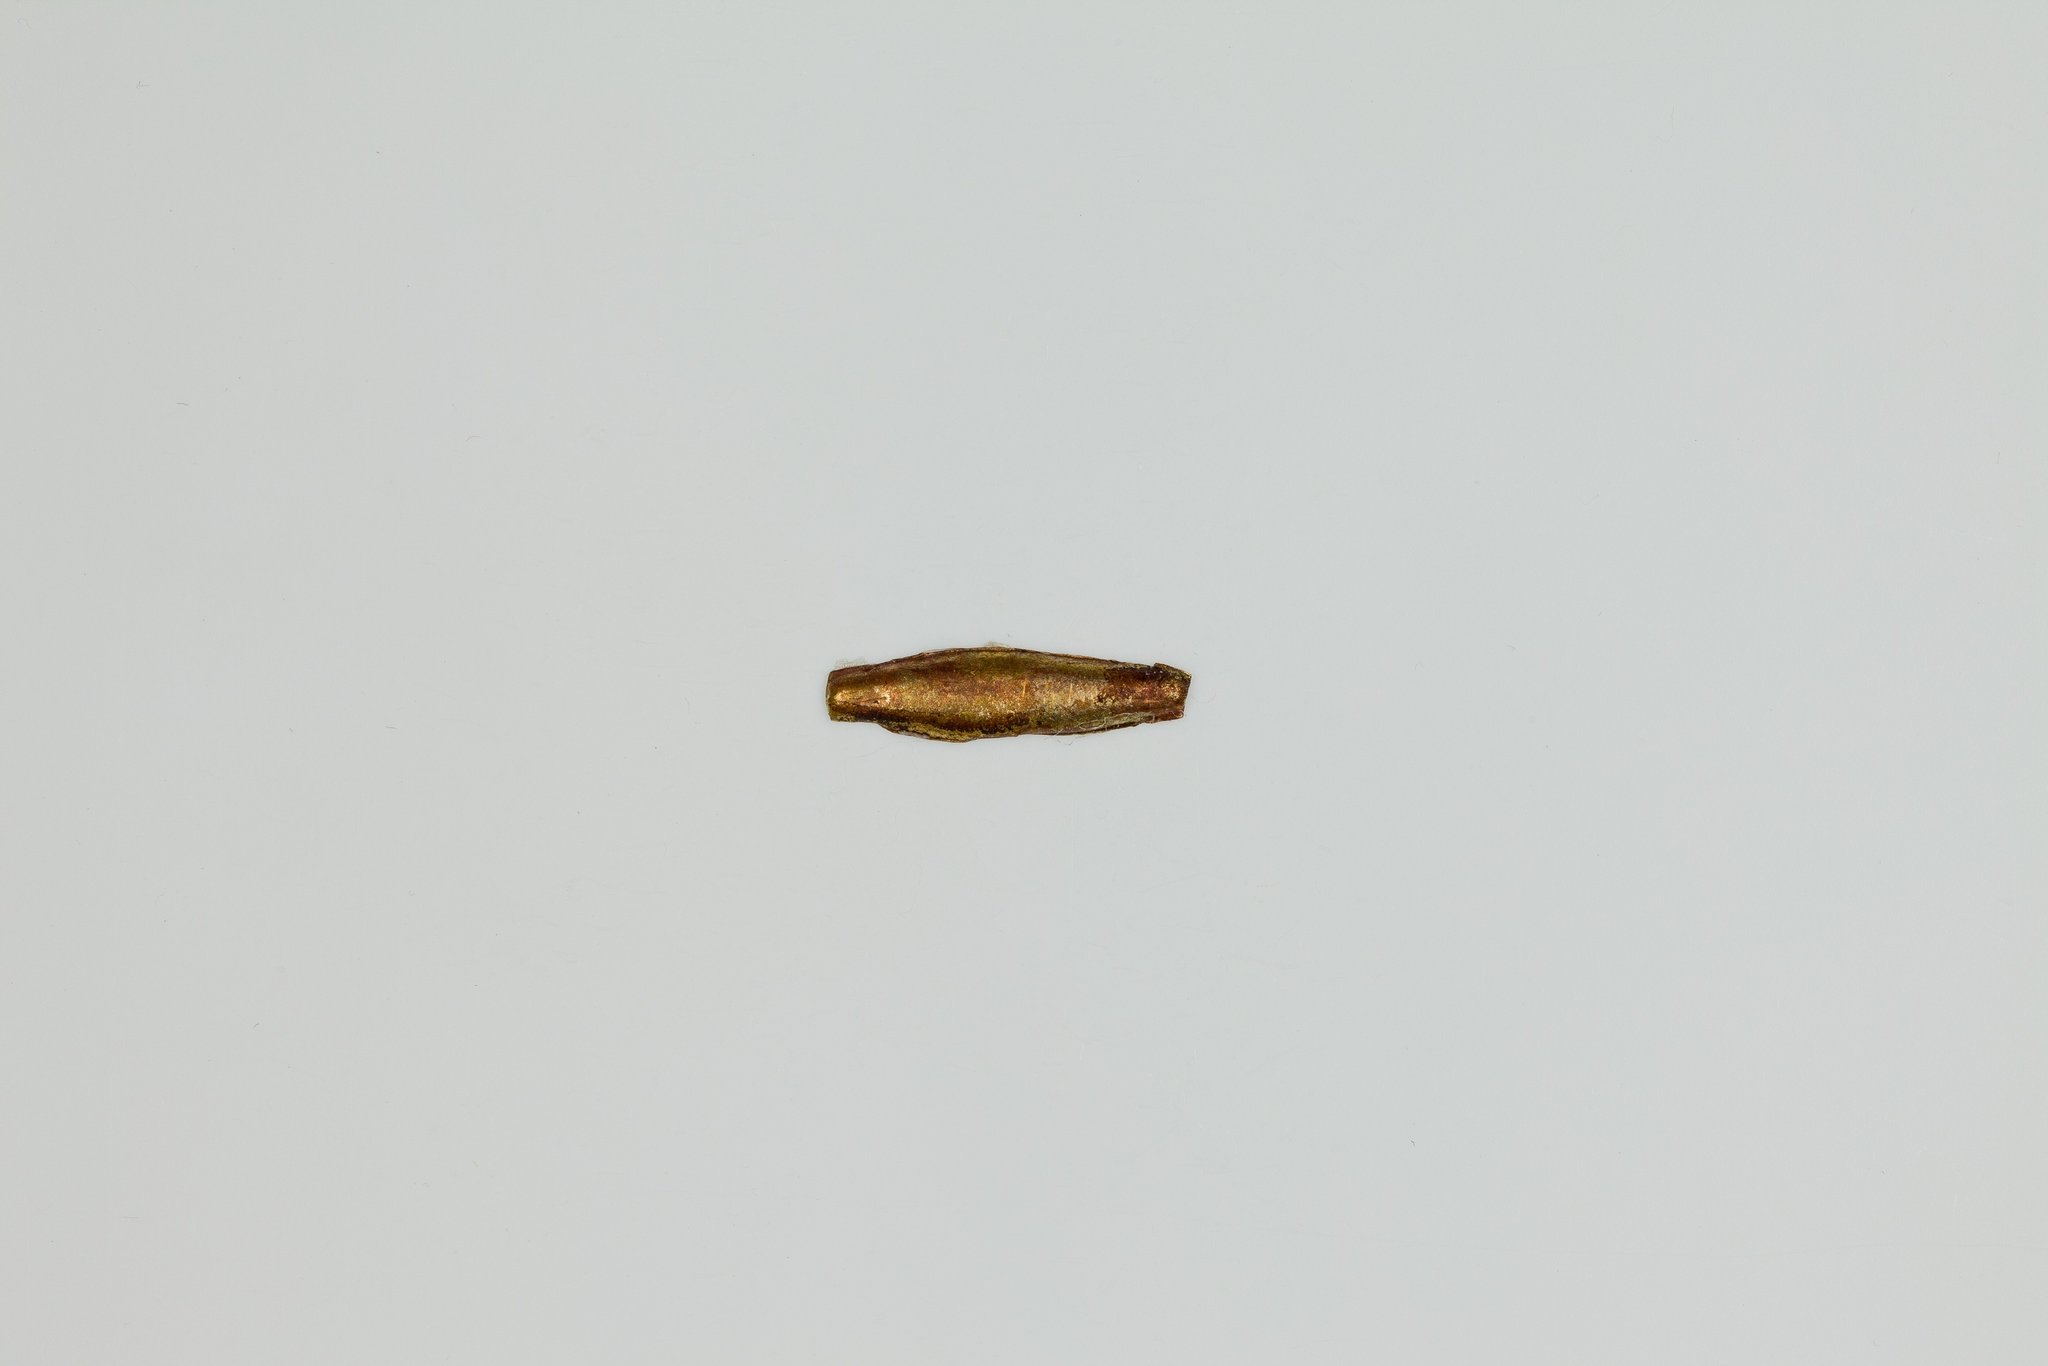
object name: amulet, sweret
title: Sweret amulet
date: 664-380 BCE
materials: gold